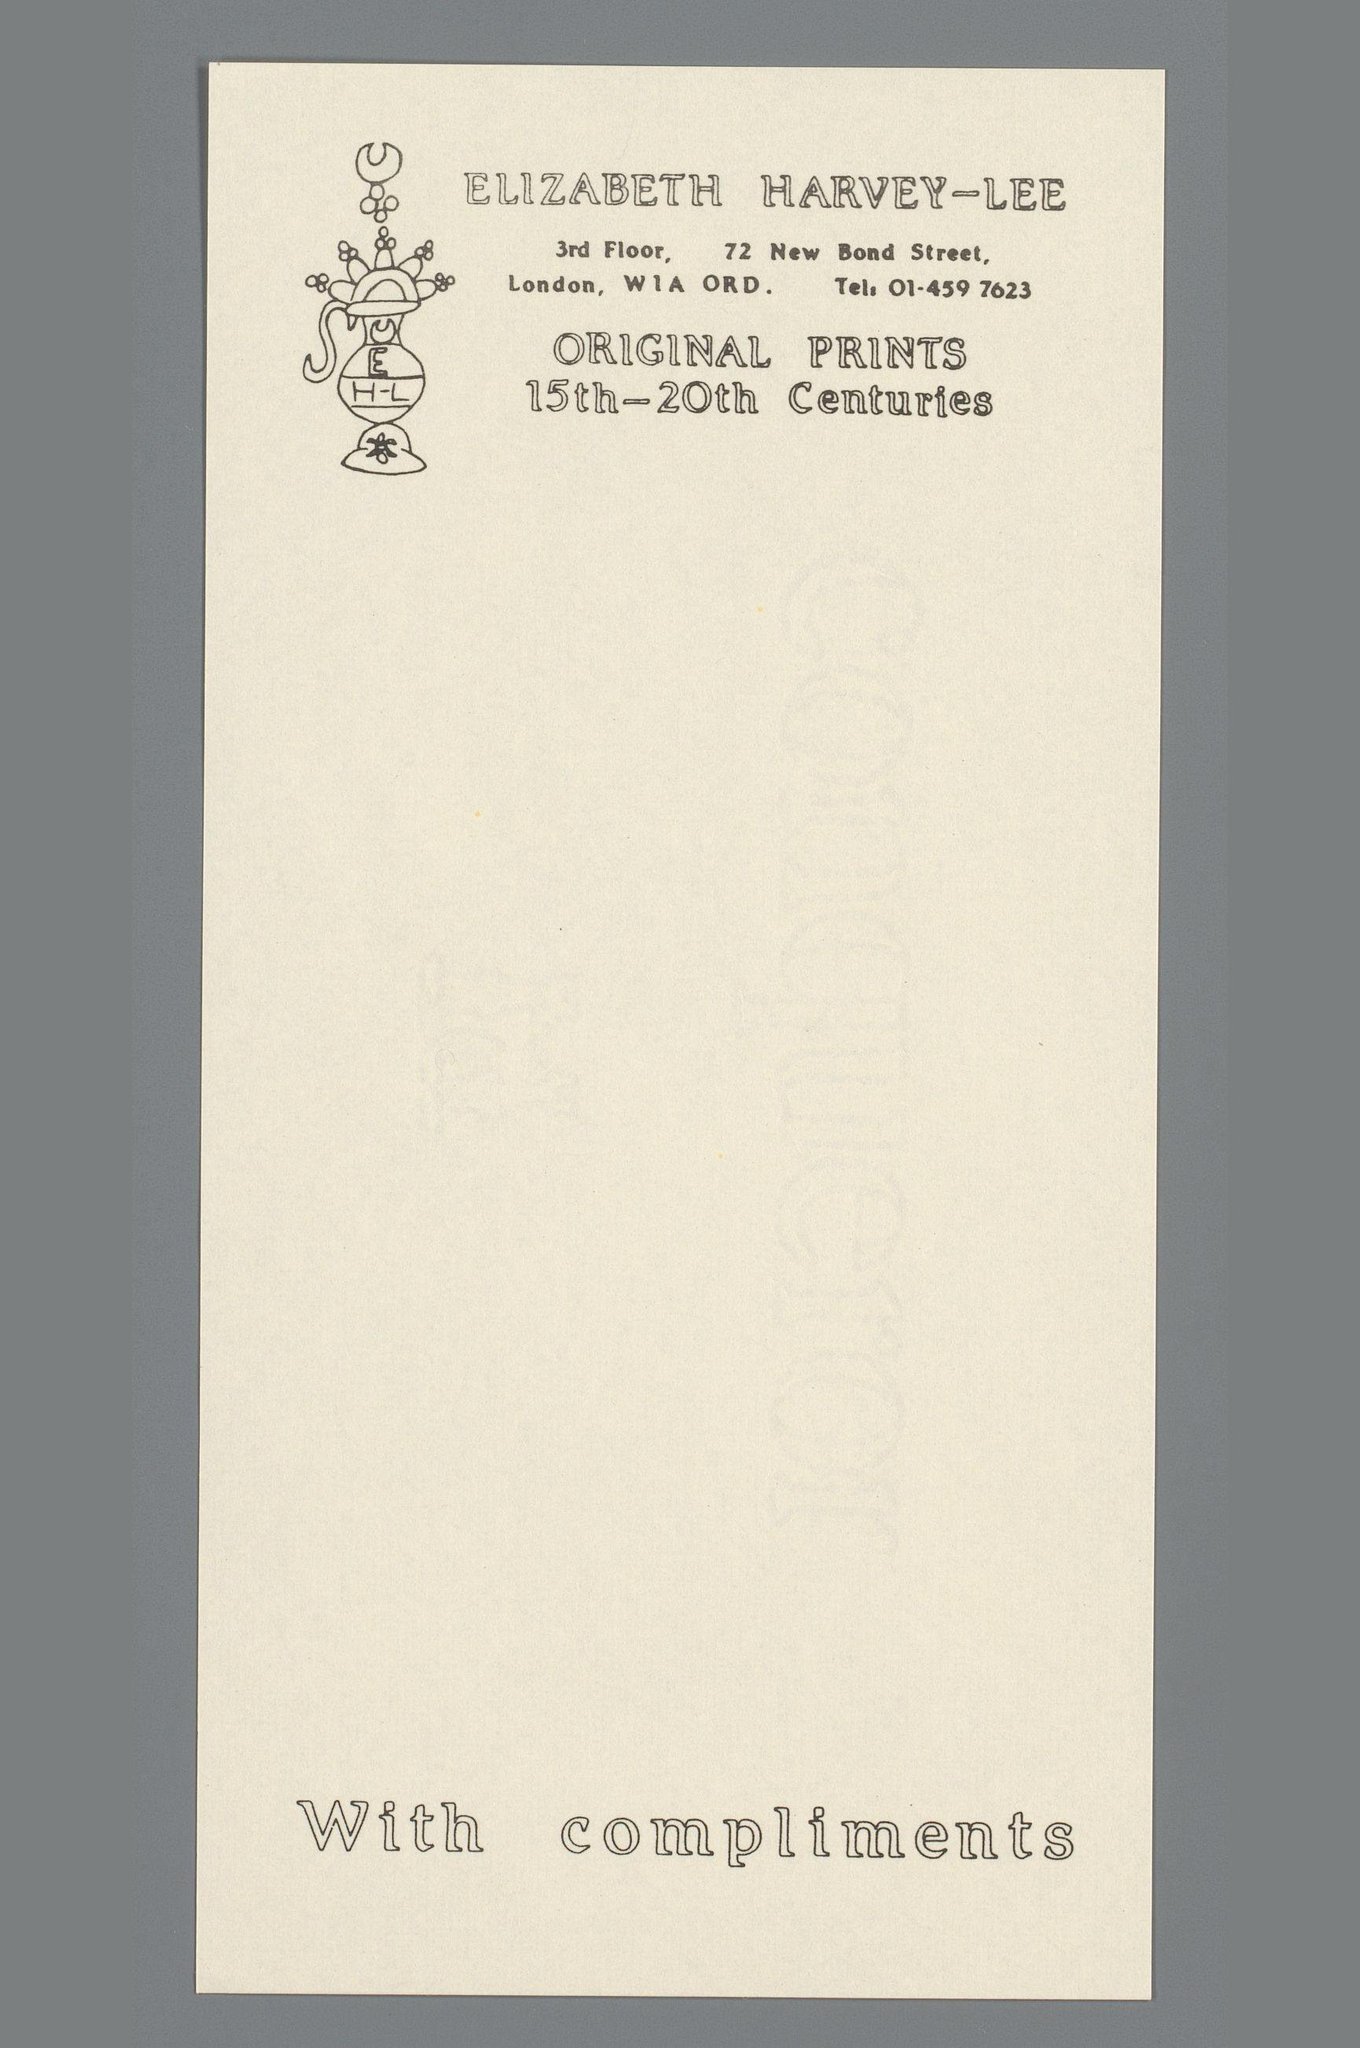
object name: stationery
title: Briefpapier van de prenthandelaar Elizabeth Harvey-Lee, Londen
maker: Anonymous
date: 1985-1995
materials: paper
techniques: printing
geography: england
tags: london